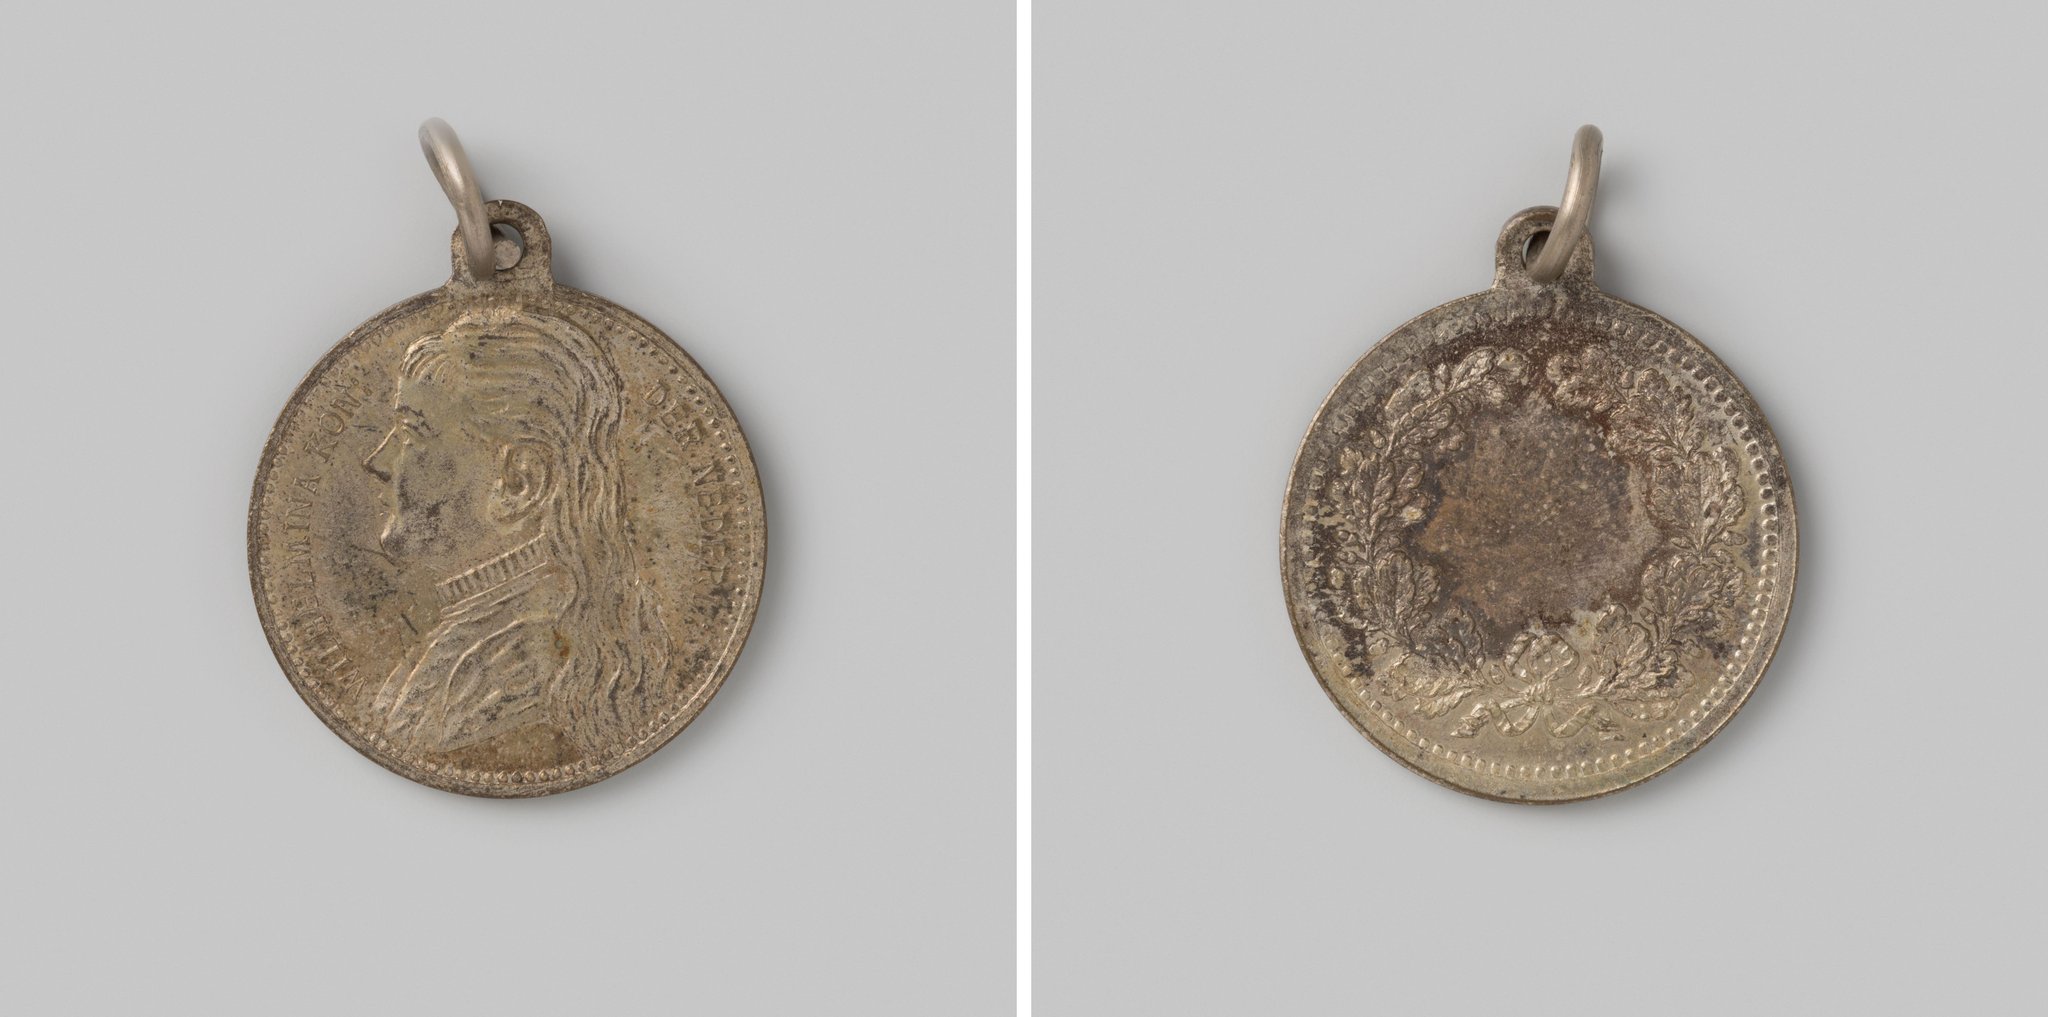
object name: history medal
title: Inhuldiging van Koningin Wilhelmina e Amsterdam 1898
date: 1898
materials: silver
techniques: striking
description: Verzilverde penning met oog en draagring, op de voorzijde het borstbeeld van Wilhelmina met lang haar naar links, met omschrift, op de keerzijde een leeg veld tussen twee samengestrikte eikentakken.